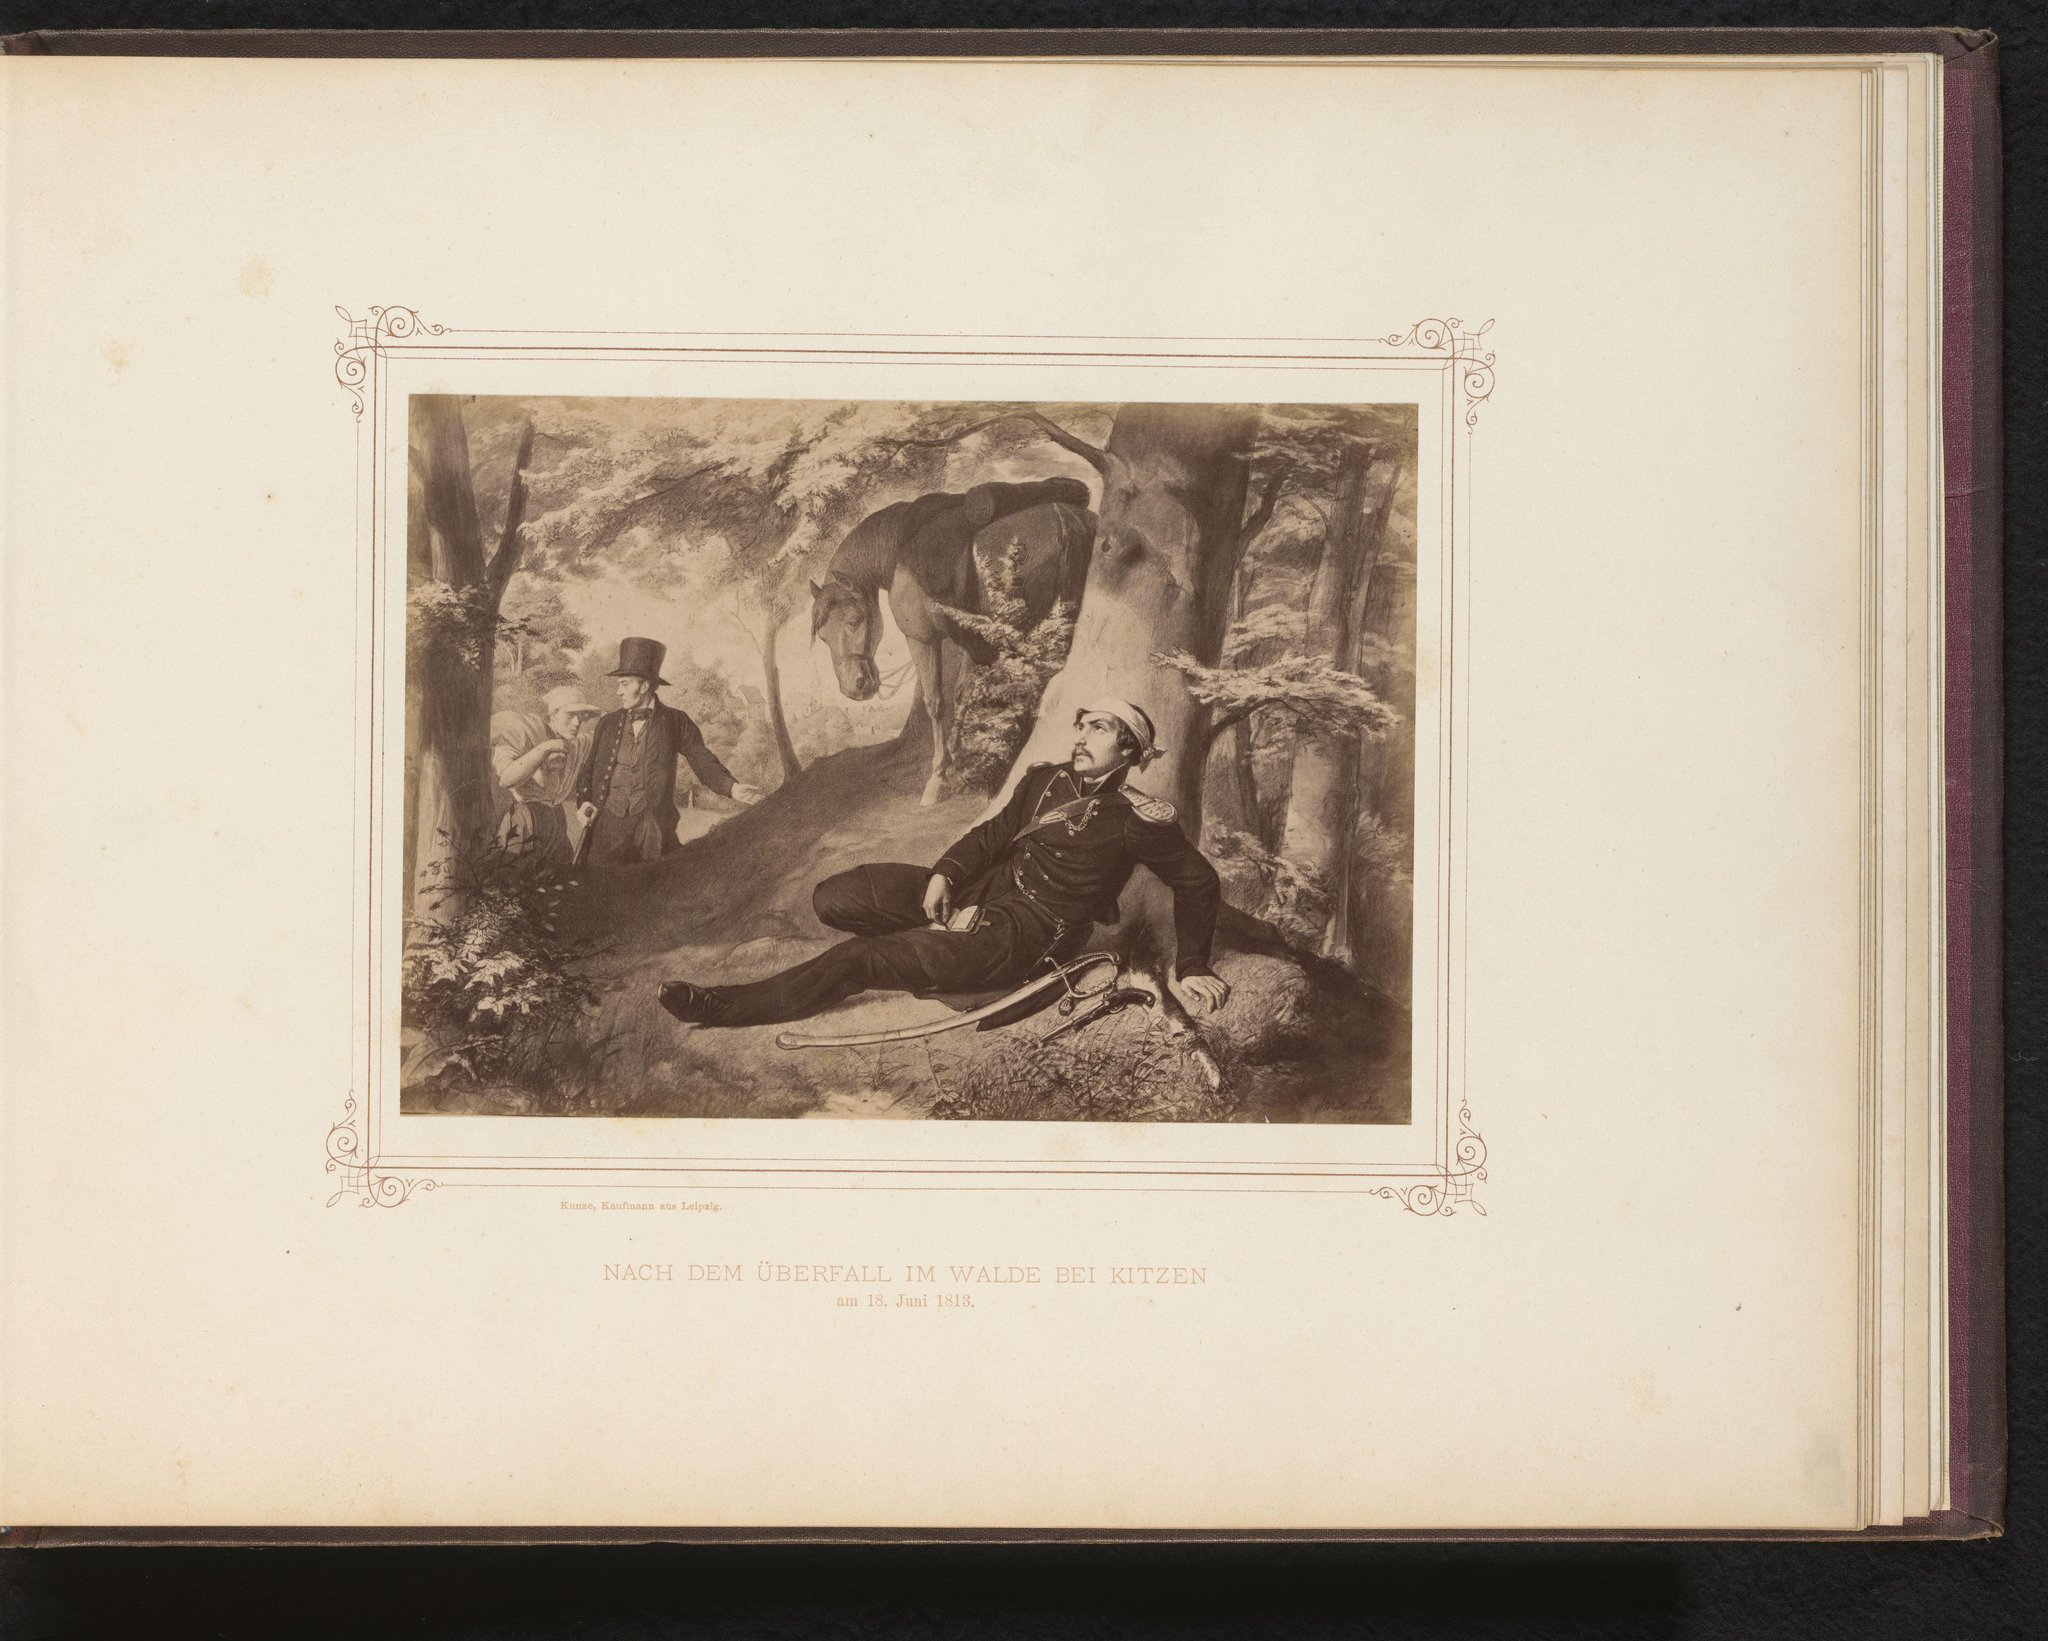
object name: page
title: Fotoreproductie van een tekening van Theodor Körner na een overval in het bos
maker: Anonymous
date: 1860-1875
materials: paper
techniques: albumen print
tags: drawing, sketch, forest, wood, being attacked; defence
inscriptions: inscription: ‘Kunze, Kaufmann aus Leipzig./ NACH DEM ÜBERFALL IM WALDE BEI KITZEN/ am 19. Juni 1813.’